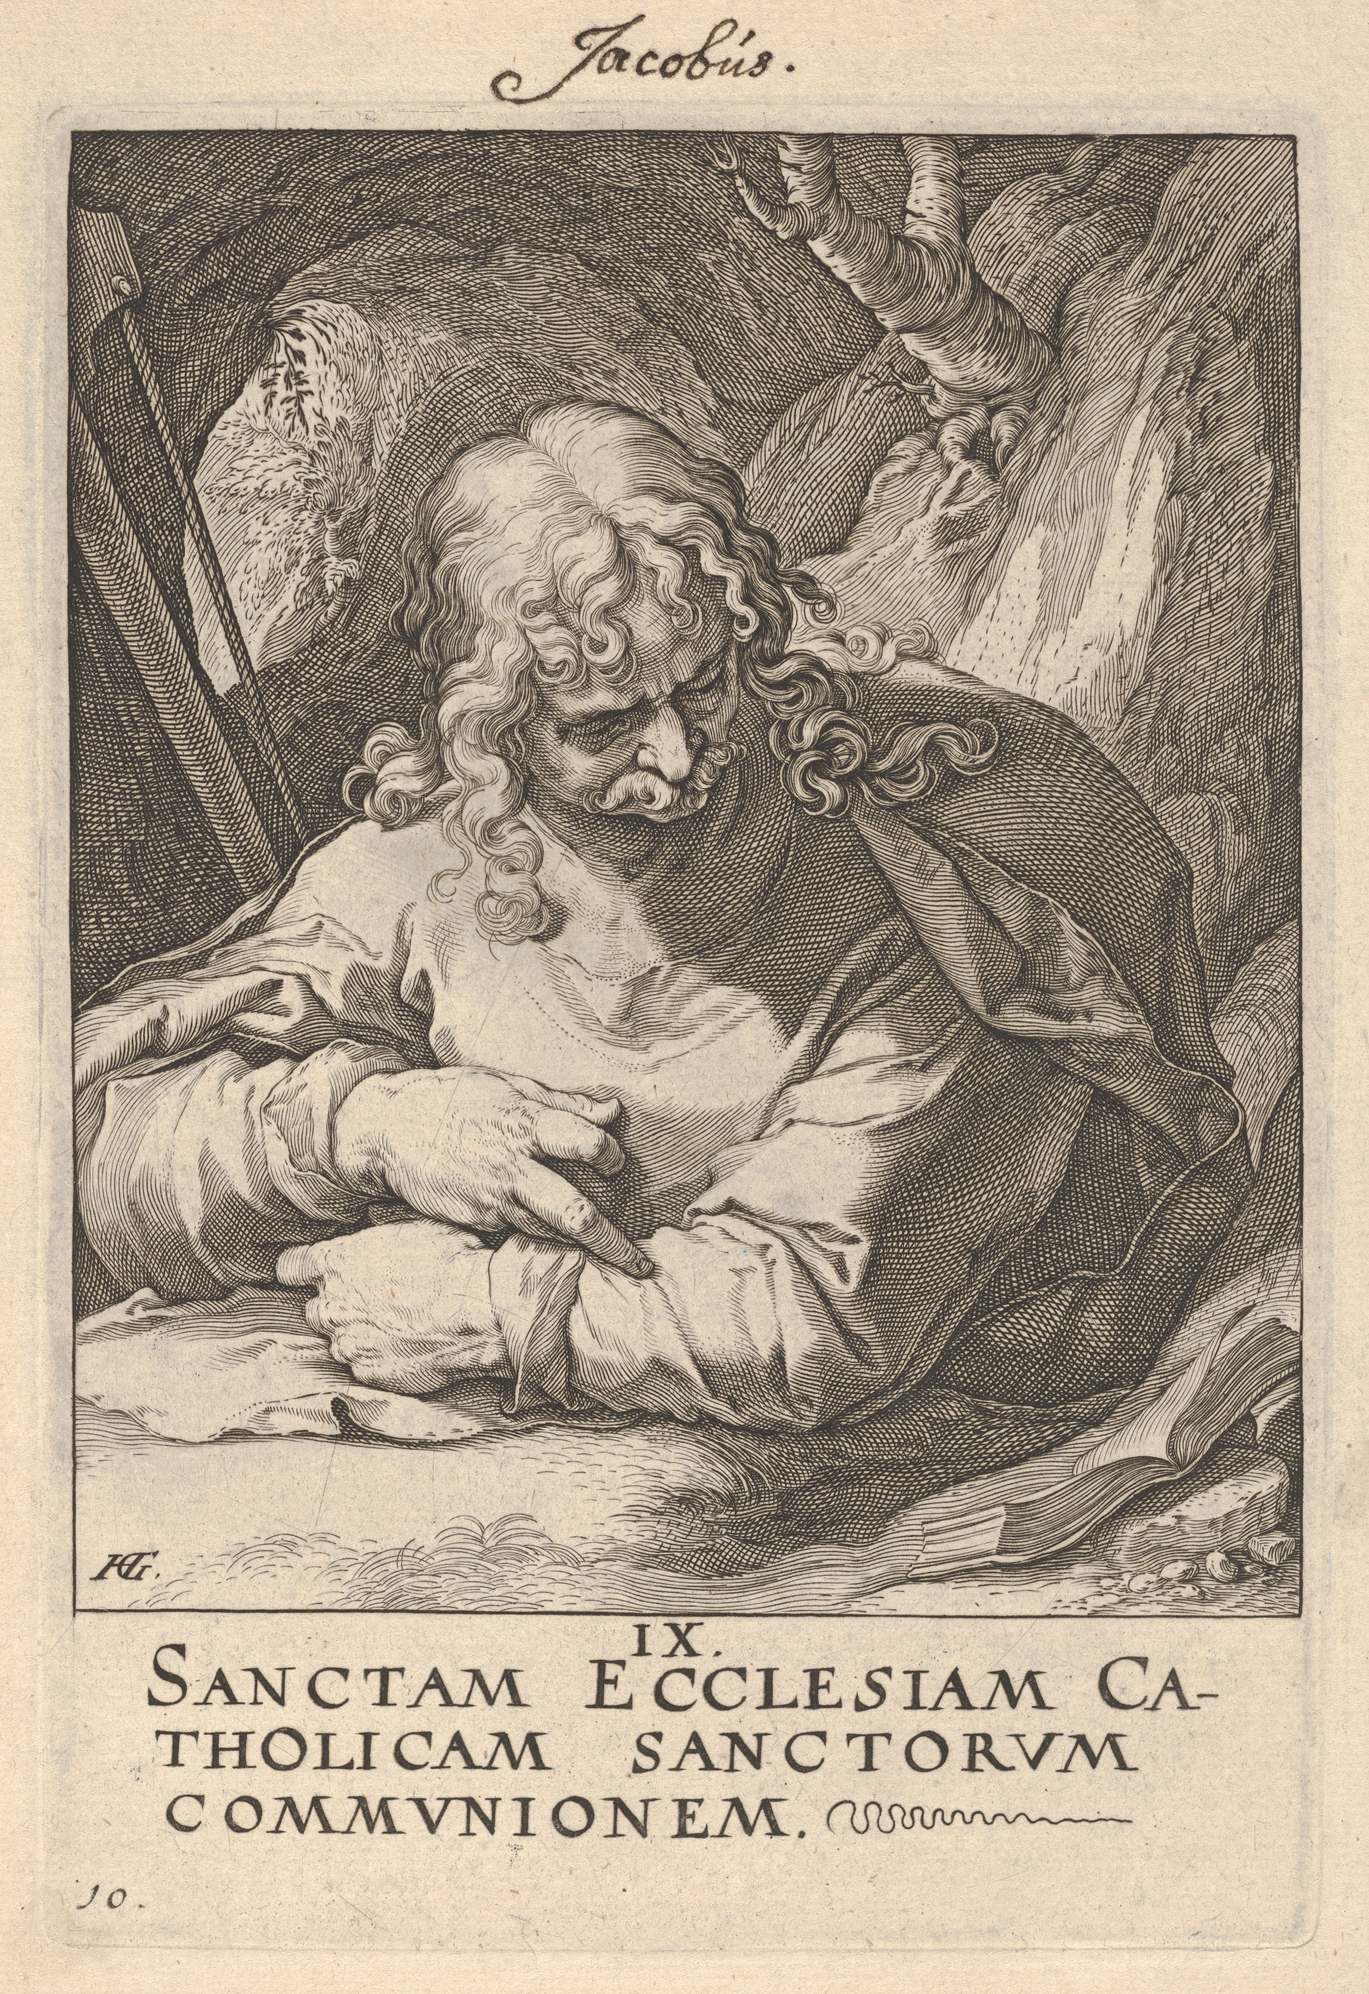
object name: print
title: St. James the Less, from "Christ, the Apostles and St. Paul with the Creed"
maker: hendrick goltzius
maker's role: artist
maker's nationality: netherlandish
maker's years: 1558-1617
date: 1589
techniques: engraving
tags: men,saints